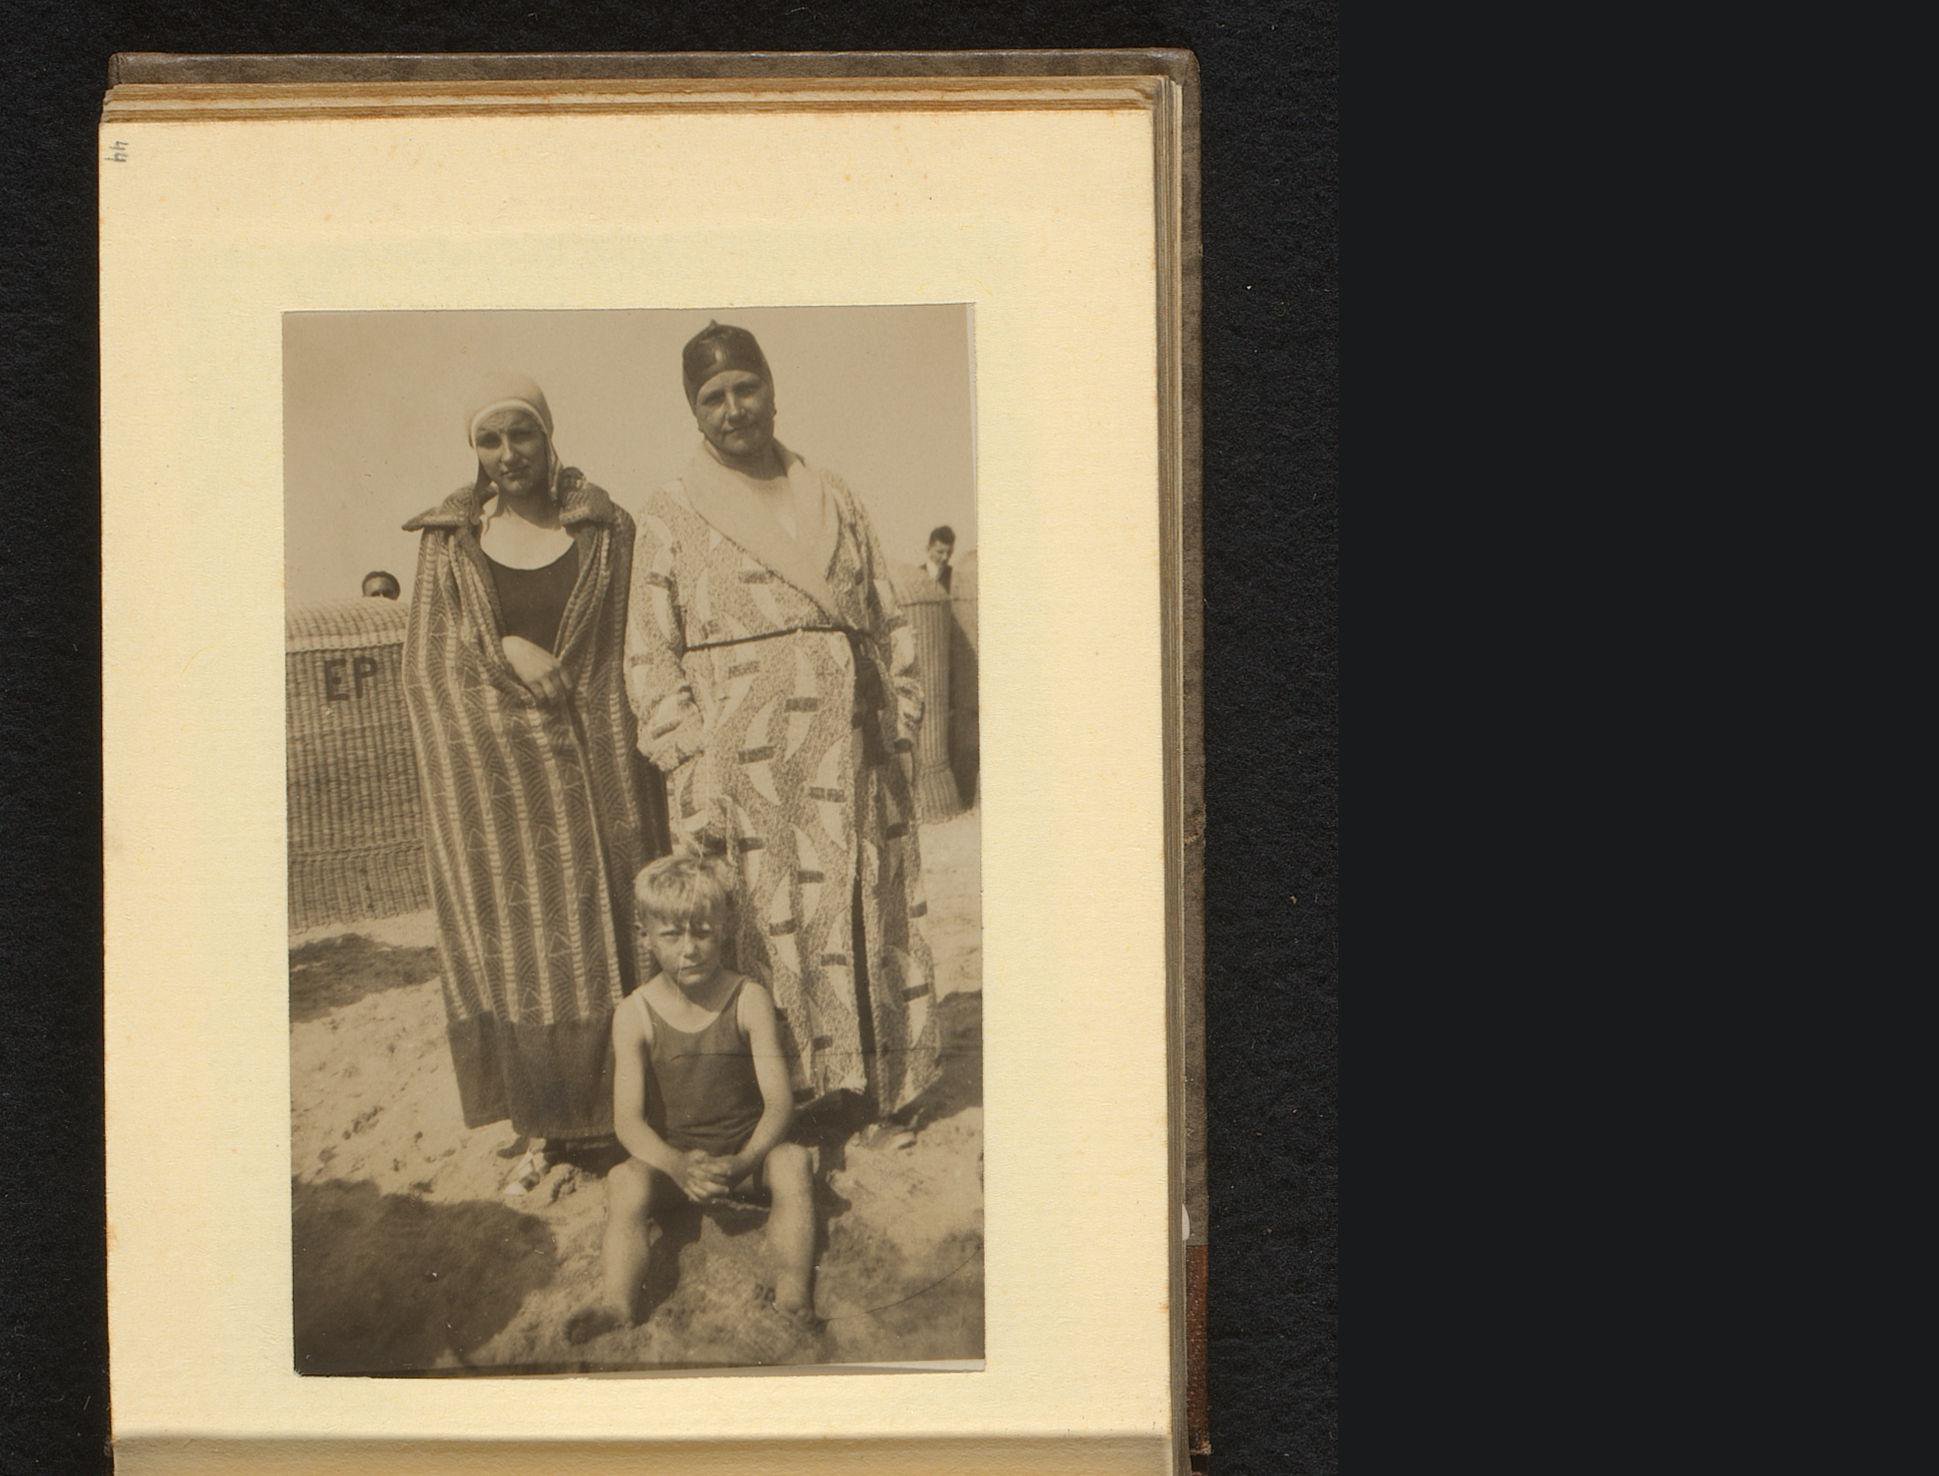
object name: photograph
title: Vrouw, man en jongen in badkleding op het strand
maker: norbert van den berg (1901-1972)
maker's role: amateurfotograaf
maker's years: 1901-1972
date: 1935-1950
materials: paper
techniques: gelatin silver print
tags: adult woman, adult man, child, beach